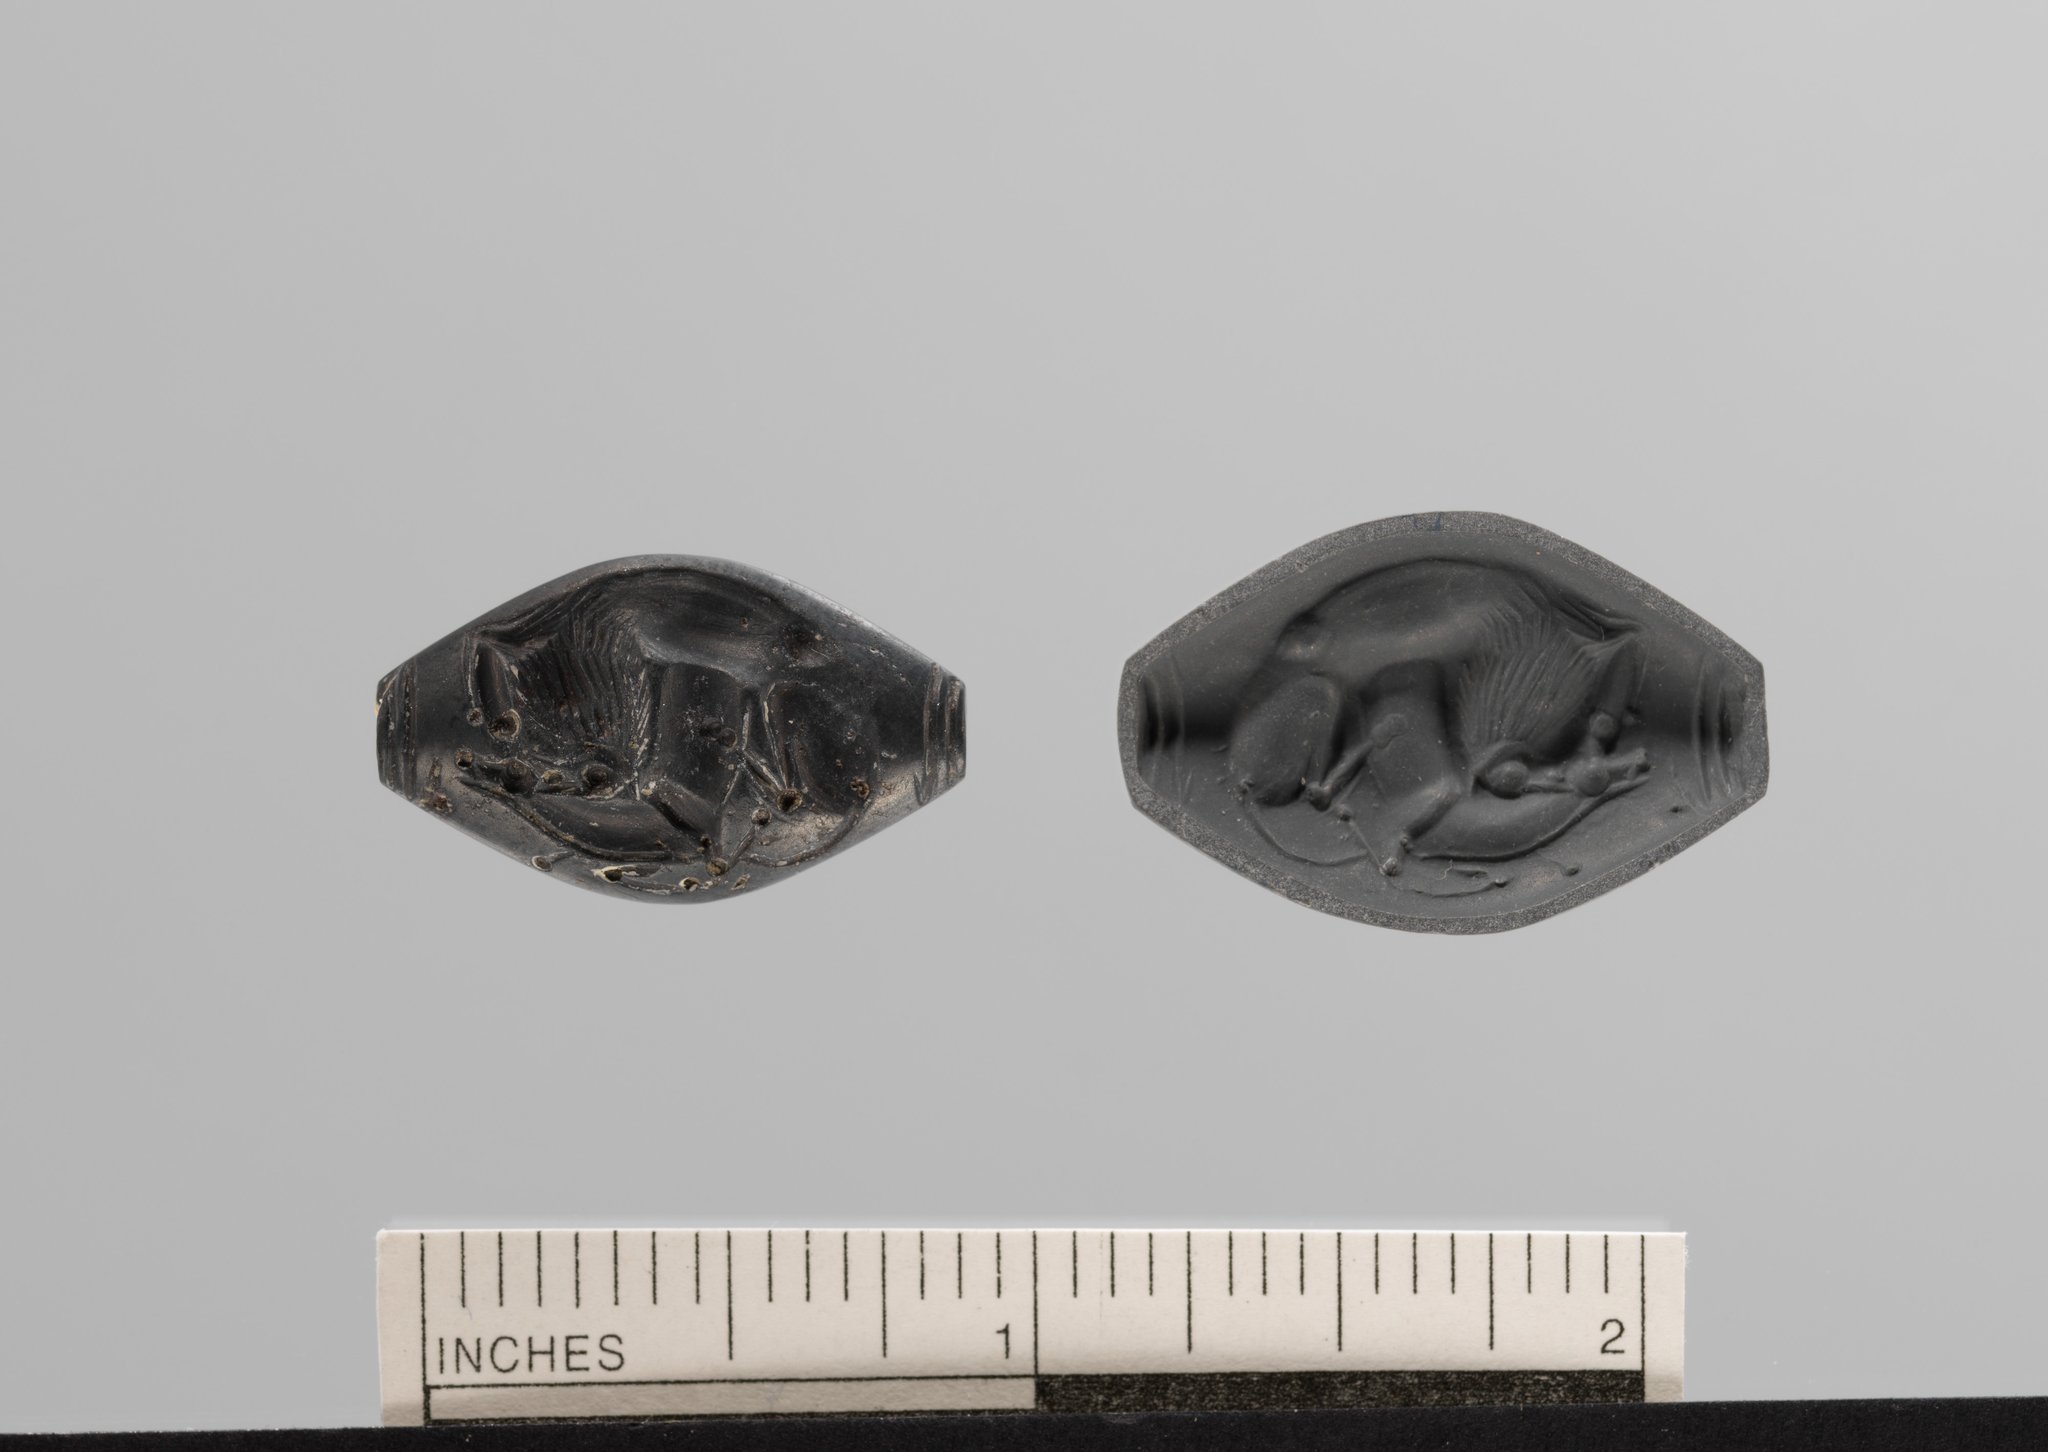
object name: seal, amygdaloid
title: Hematite Amygdaloid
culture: minoan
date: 1500-1400 BCE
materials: mineral